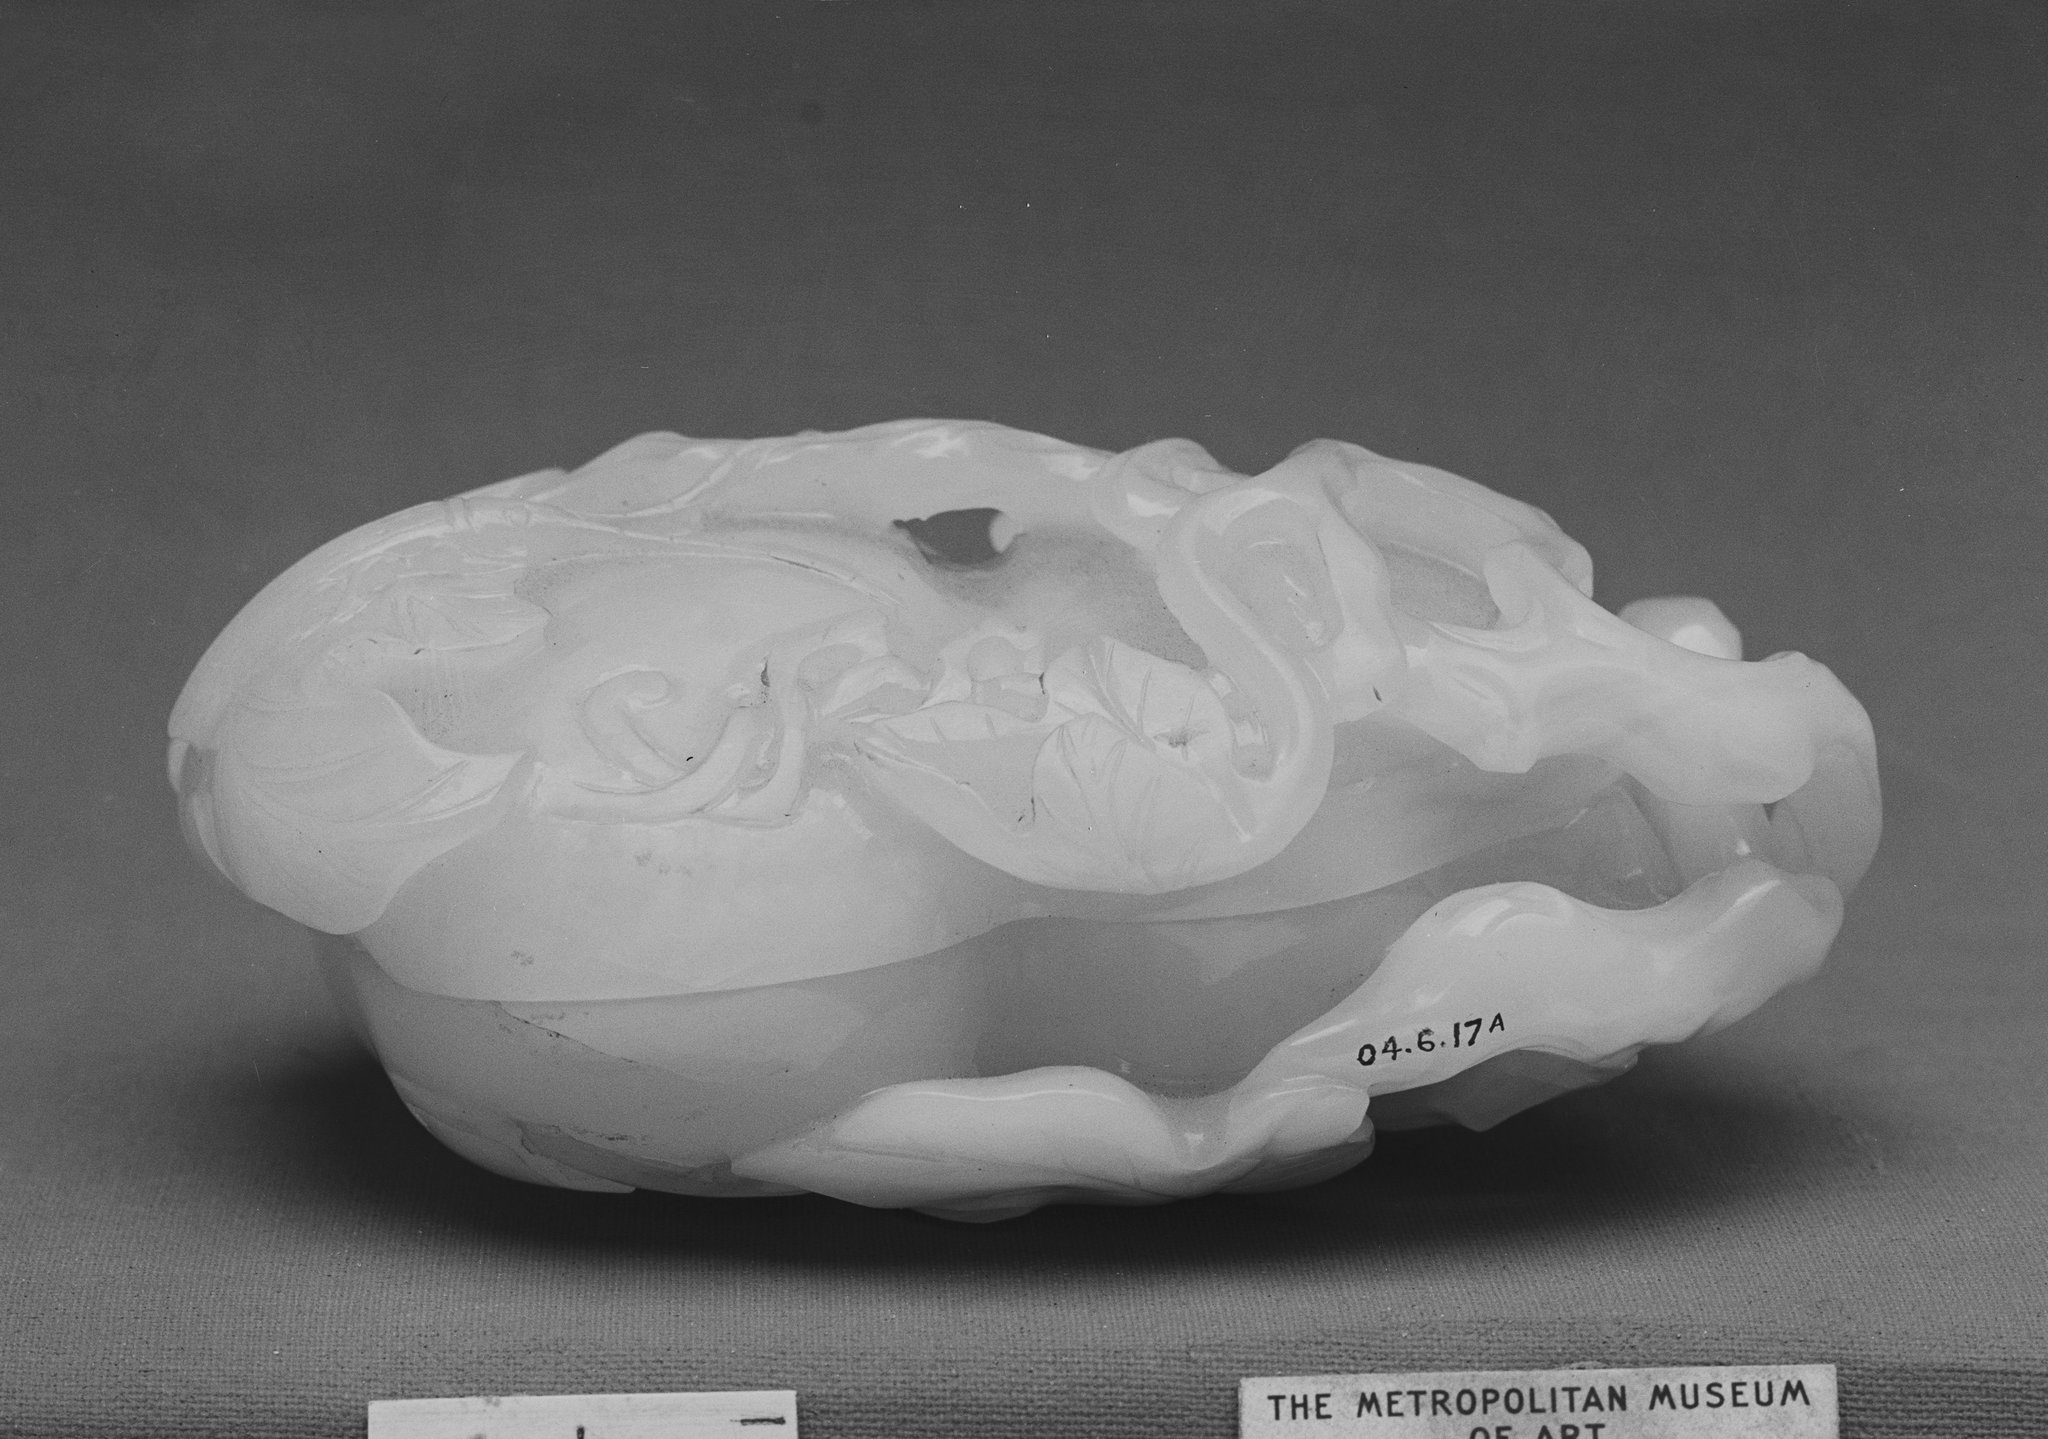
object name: covered box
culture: chinese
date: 1736-1795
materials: jade